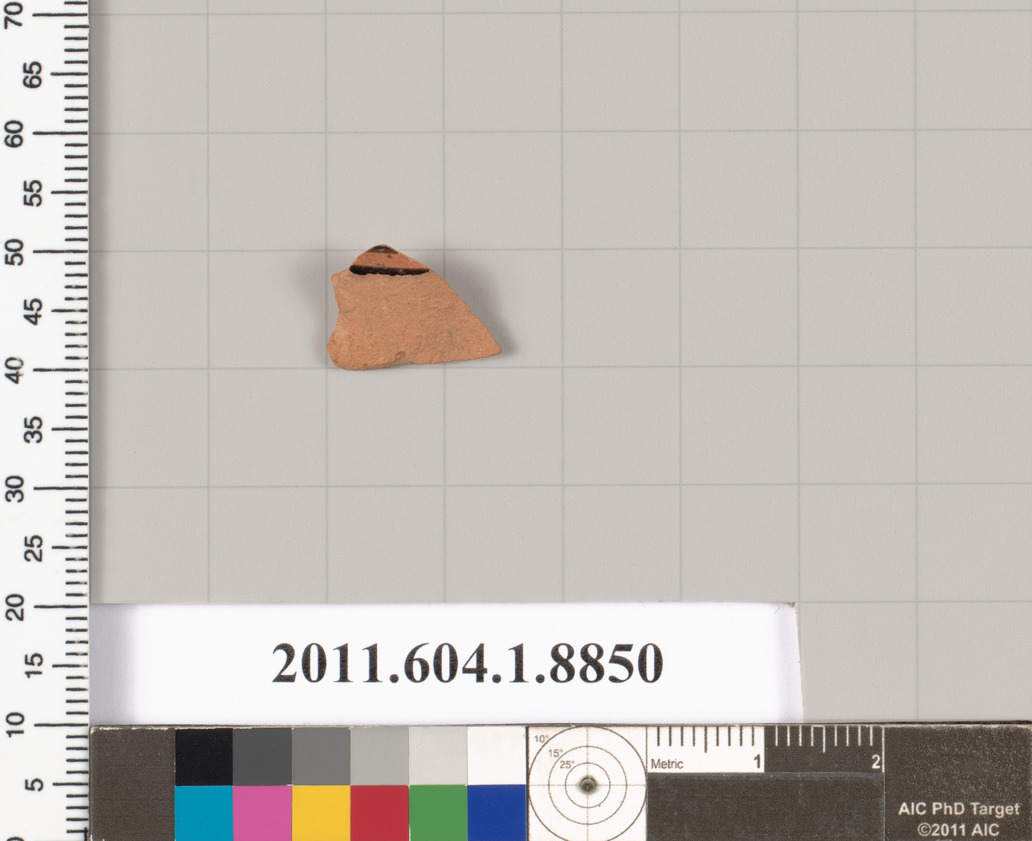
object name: kylix fragment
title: Terracotta fragment of a kylix (drinking cup)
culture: greek, attic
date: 500-470 BCE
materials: terracotta